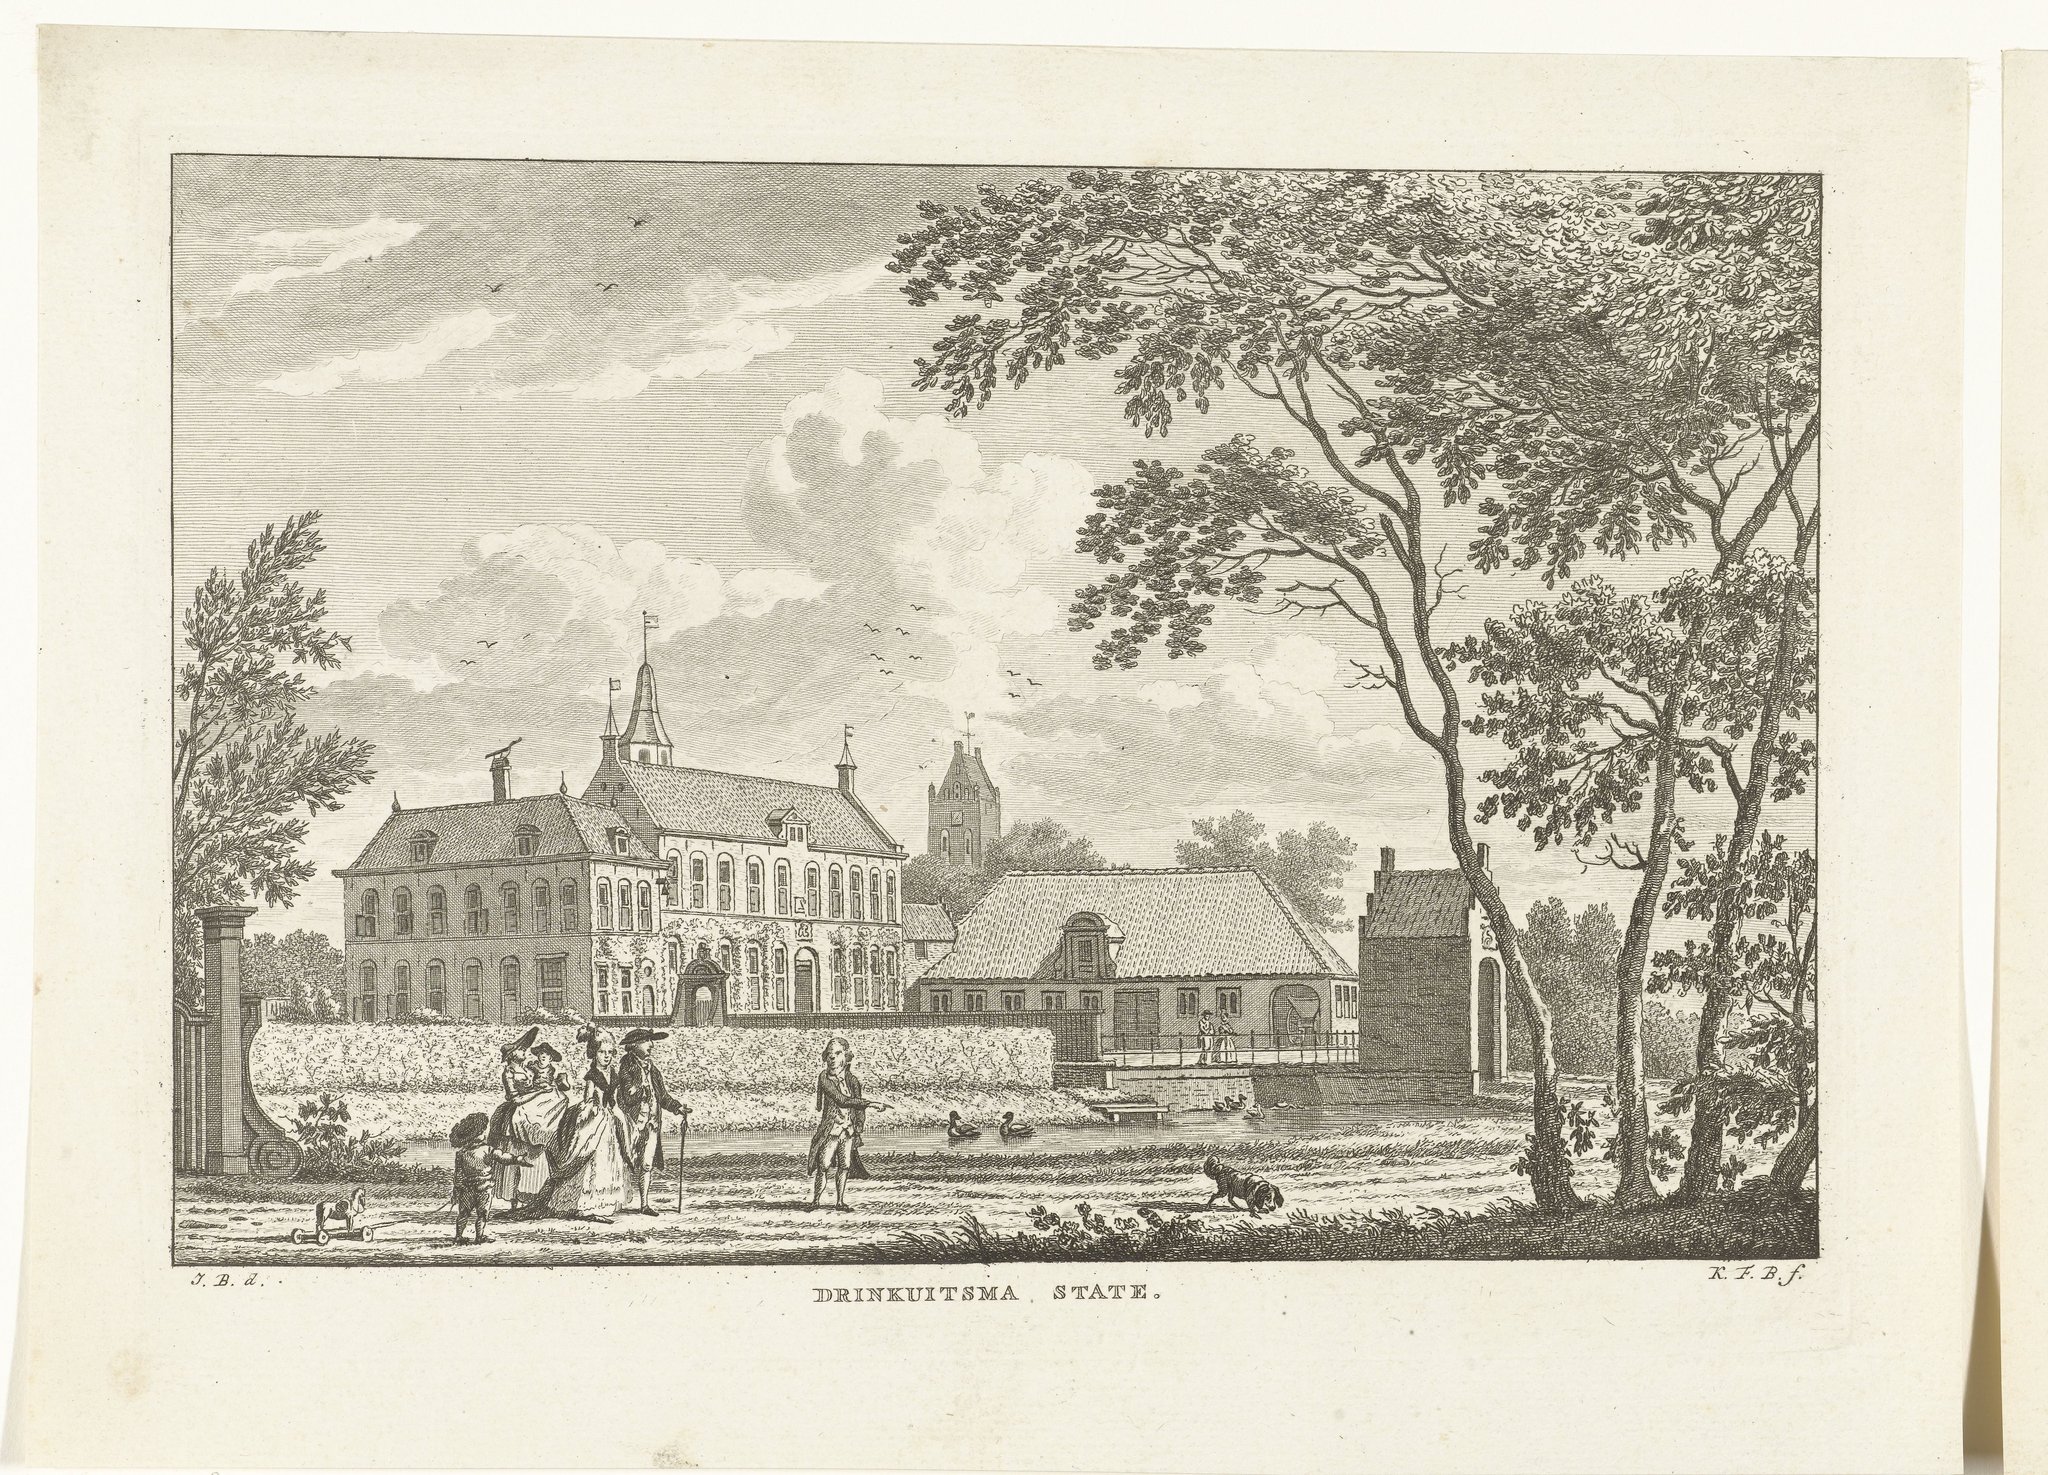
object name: print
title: Drinkuitsma State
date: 1786-1792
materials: paper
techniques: etching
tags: country-house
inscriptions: collector's mark: Lugt 2228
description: Prent uit: Vaderlandsche gezichten, of afbeeldingen van den tegenwoordigen staat der Vereenigde Nederlanden (…). Amsterdam: Hendrik Gartman, Willem Vermandel en Jan Willem Smit, 1786-1792. Uitgegeven in afleveringen met ieder een eigen bifolium en inhoudsopgave. Alle prenten in deze publicatie zijn gegraveerd door Carel Frederik Bendorp (I) en, in de meeste gevallen, gebaseerd op tekeningen van Jan Bulthuis. Het opschrift vermeldt een andere benaming voor de Eminga State, Drinkuitsma State (zie http://www.stinseninfriesland.nl).